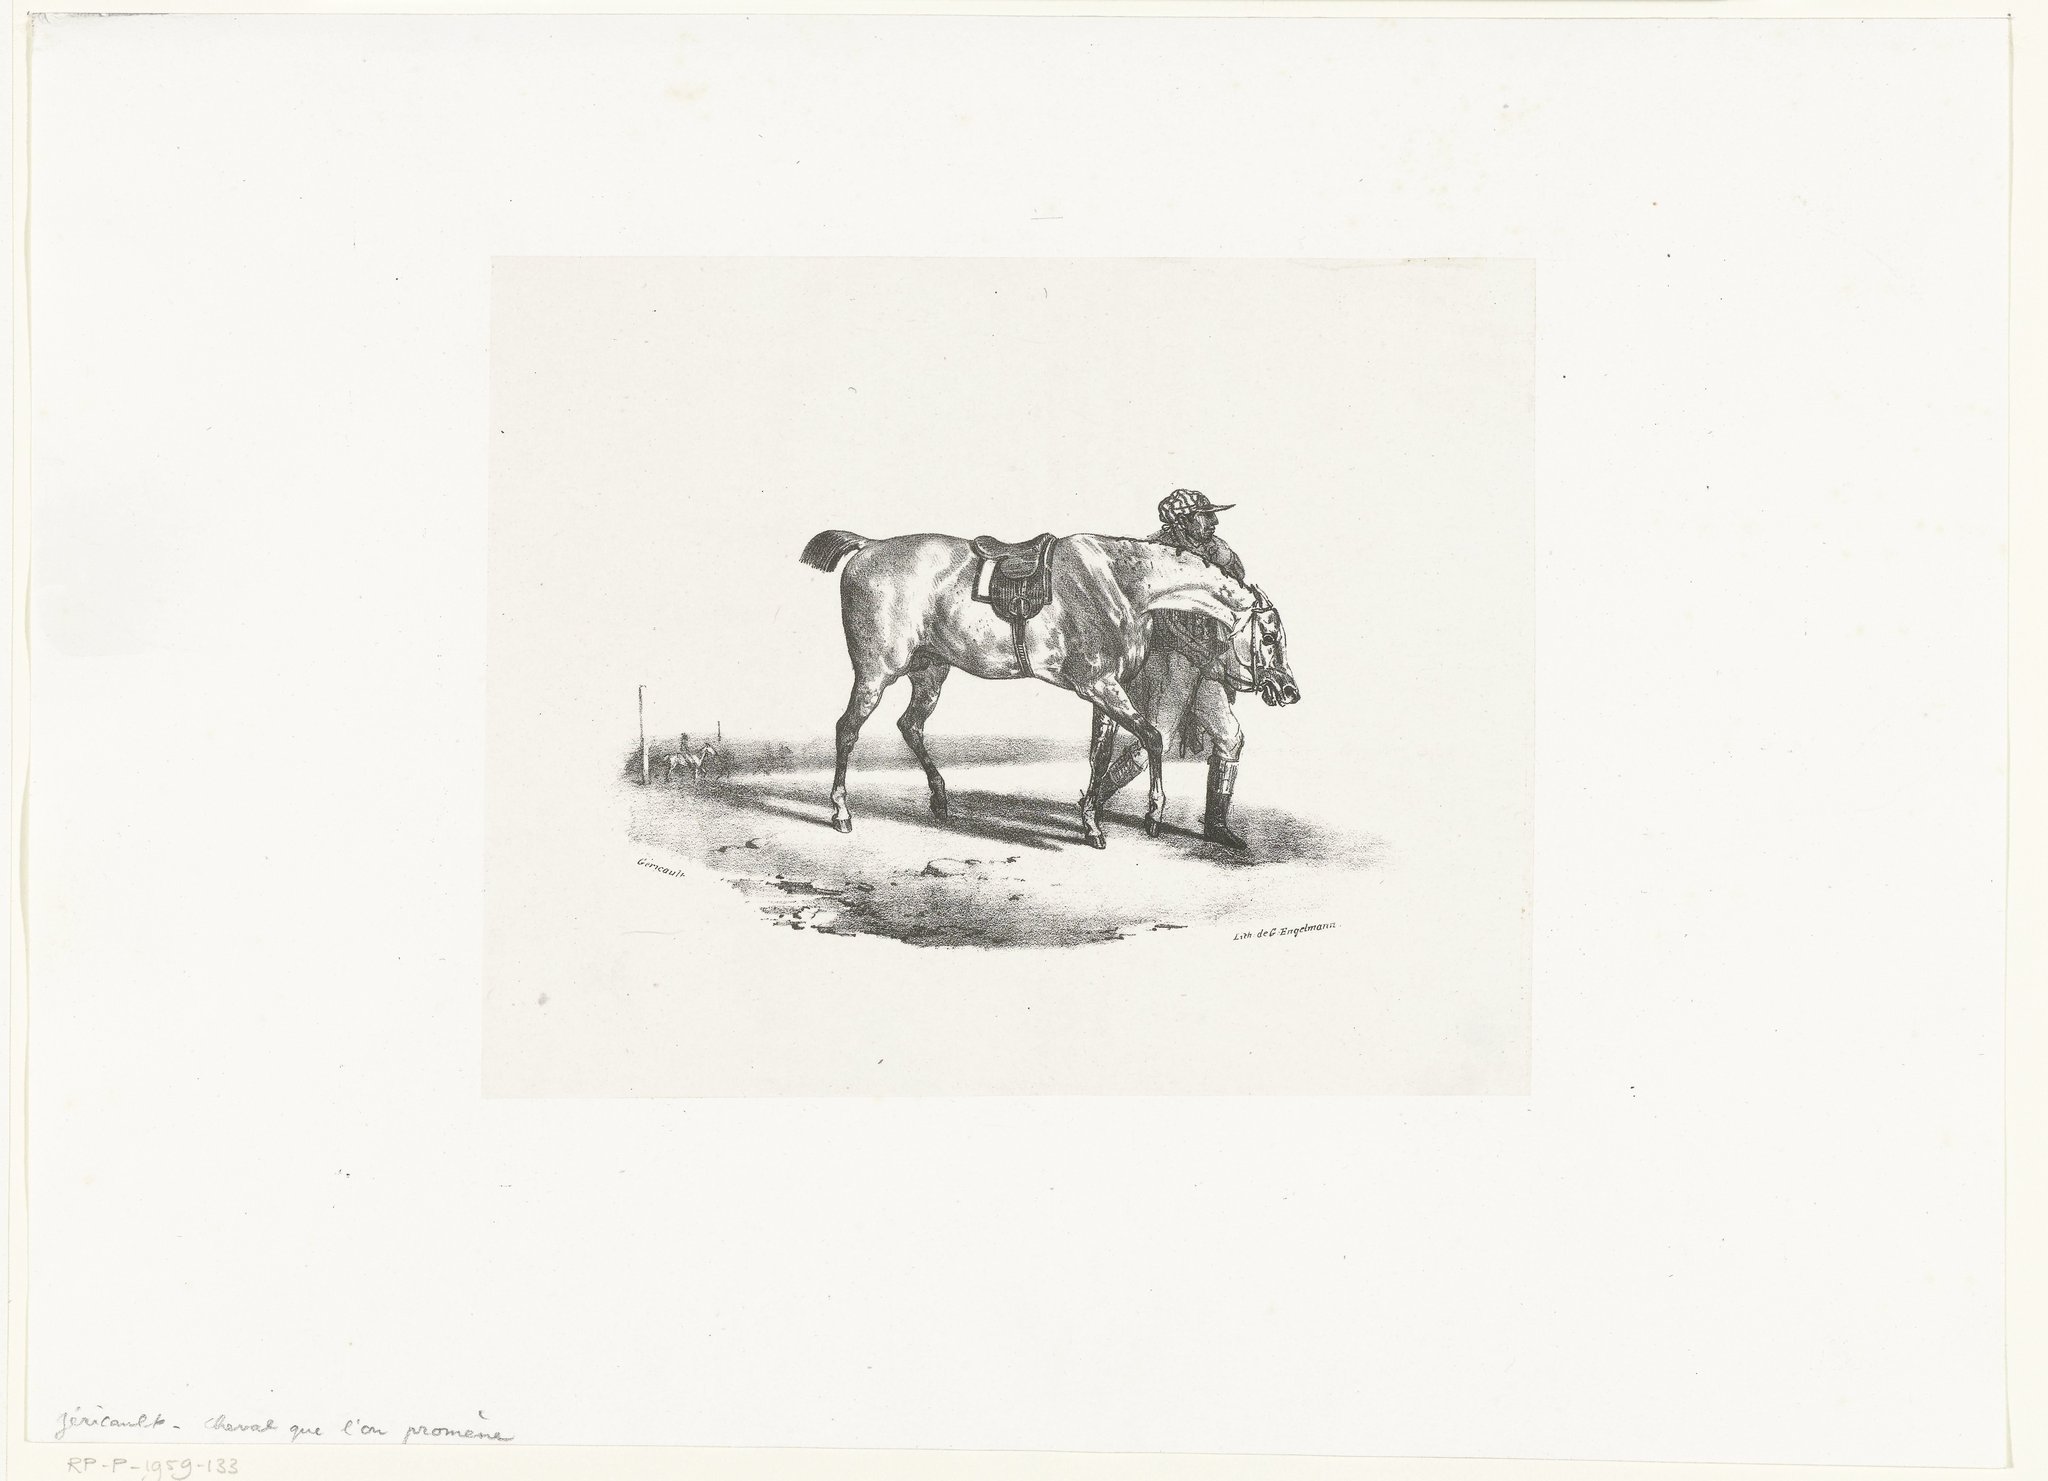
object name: print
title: Cheval que l'on promène avant la course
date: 1823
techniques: printmaking, lithograph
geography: paris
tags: race-track, jockey, horse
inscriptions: collector's mark: Lugt 2760, collector's mark: Lugt 2228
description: Een jockey loopt naast zijn paard, de teugels in zijn rechterhand. Hij draagt een paardendeken over zijn linkerschouder.